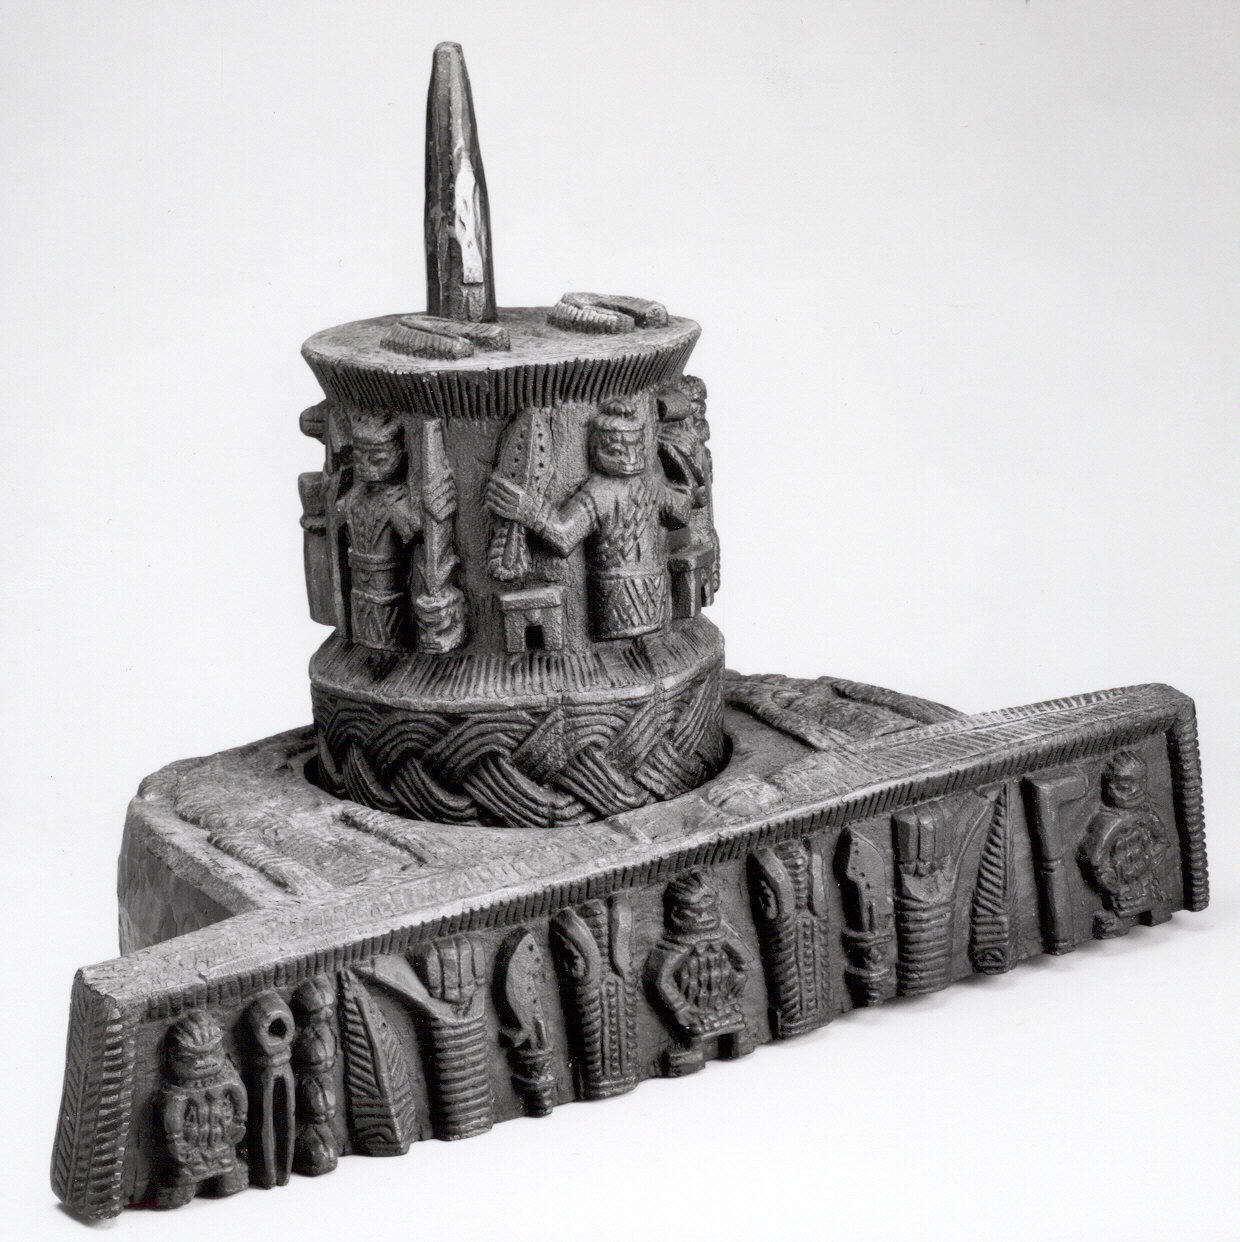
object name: altar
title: Altar to the Hand (Ikegobo)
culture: edo period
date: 1801-1900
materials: wood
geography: nigeria